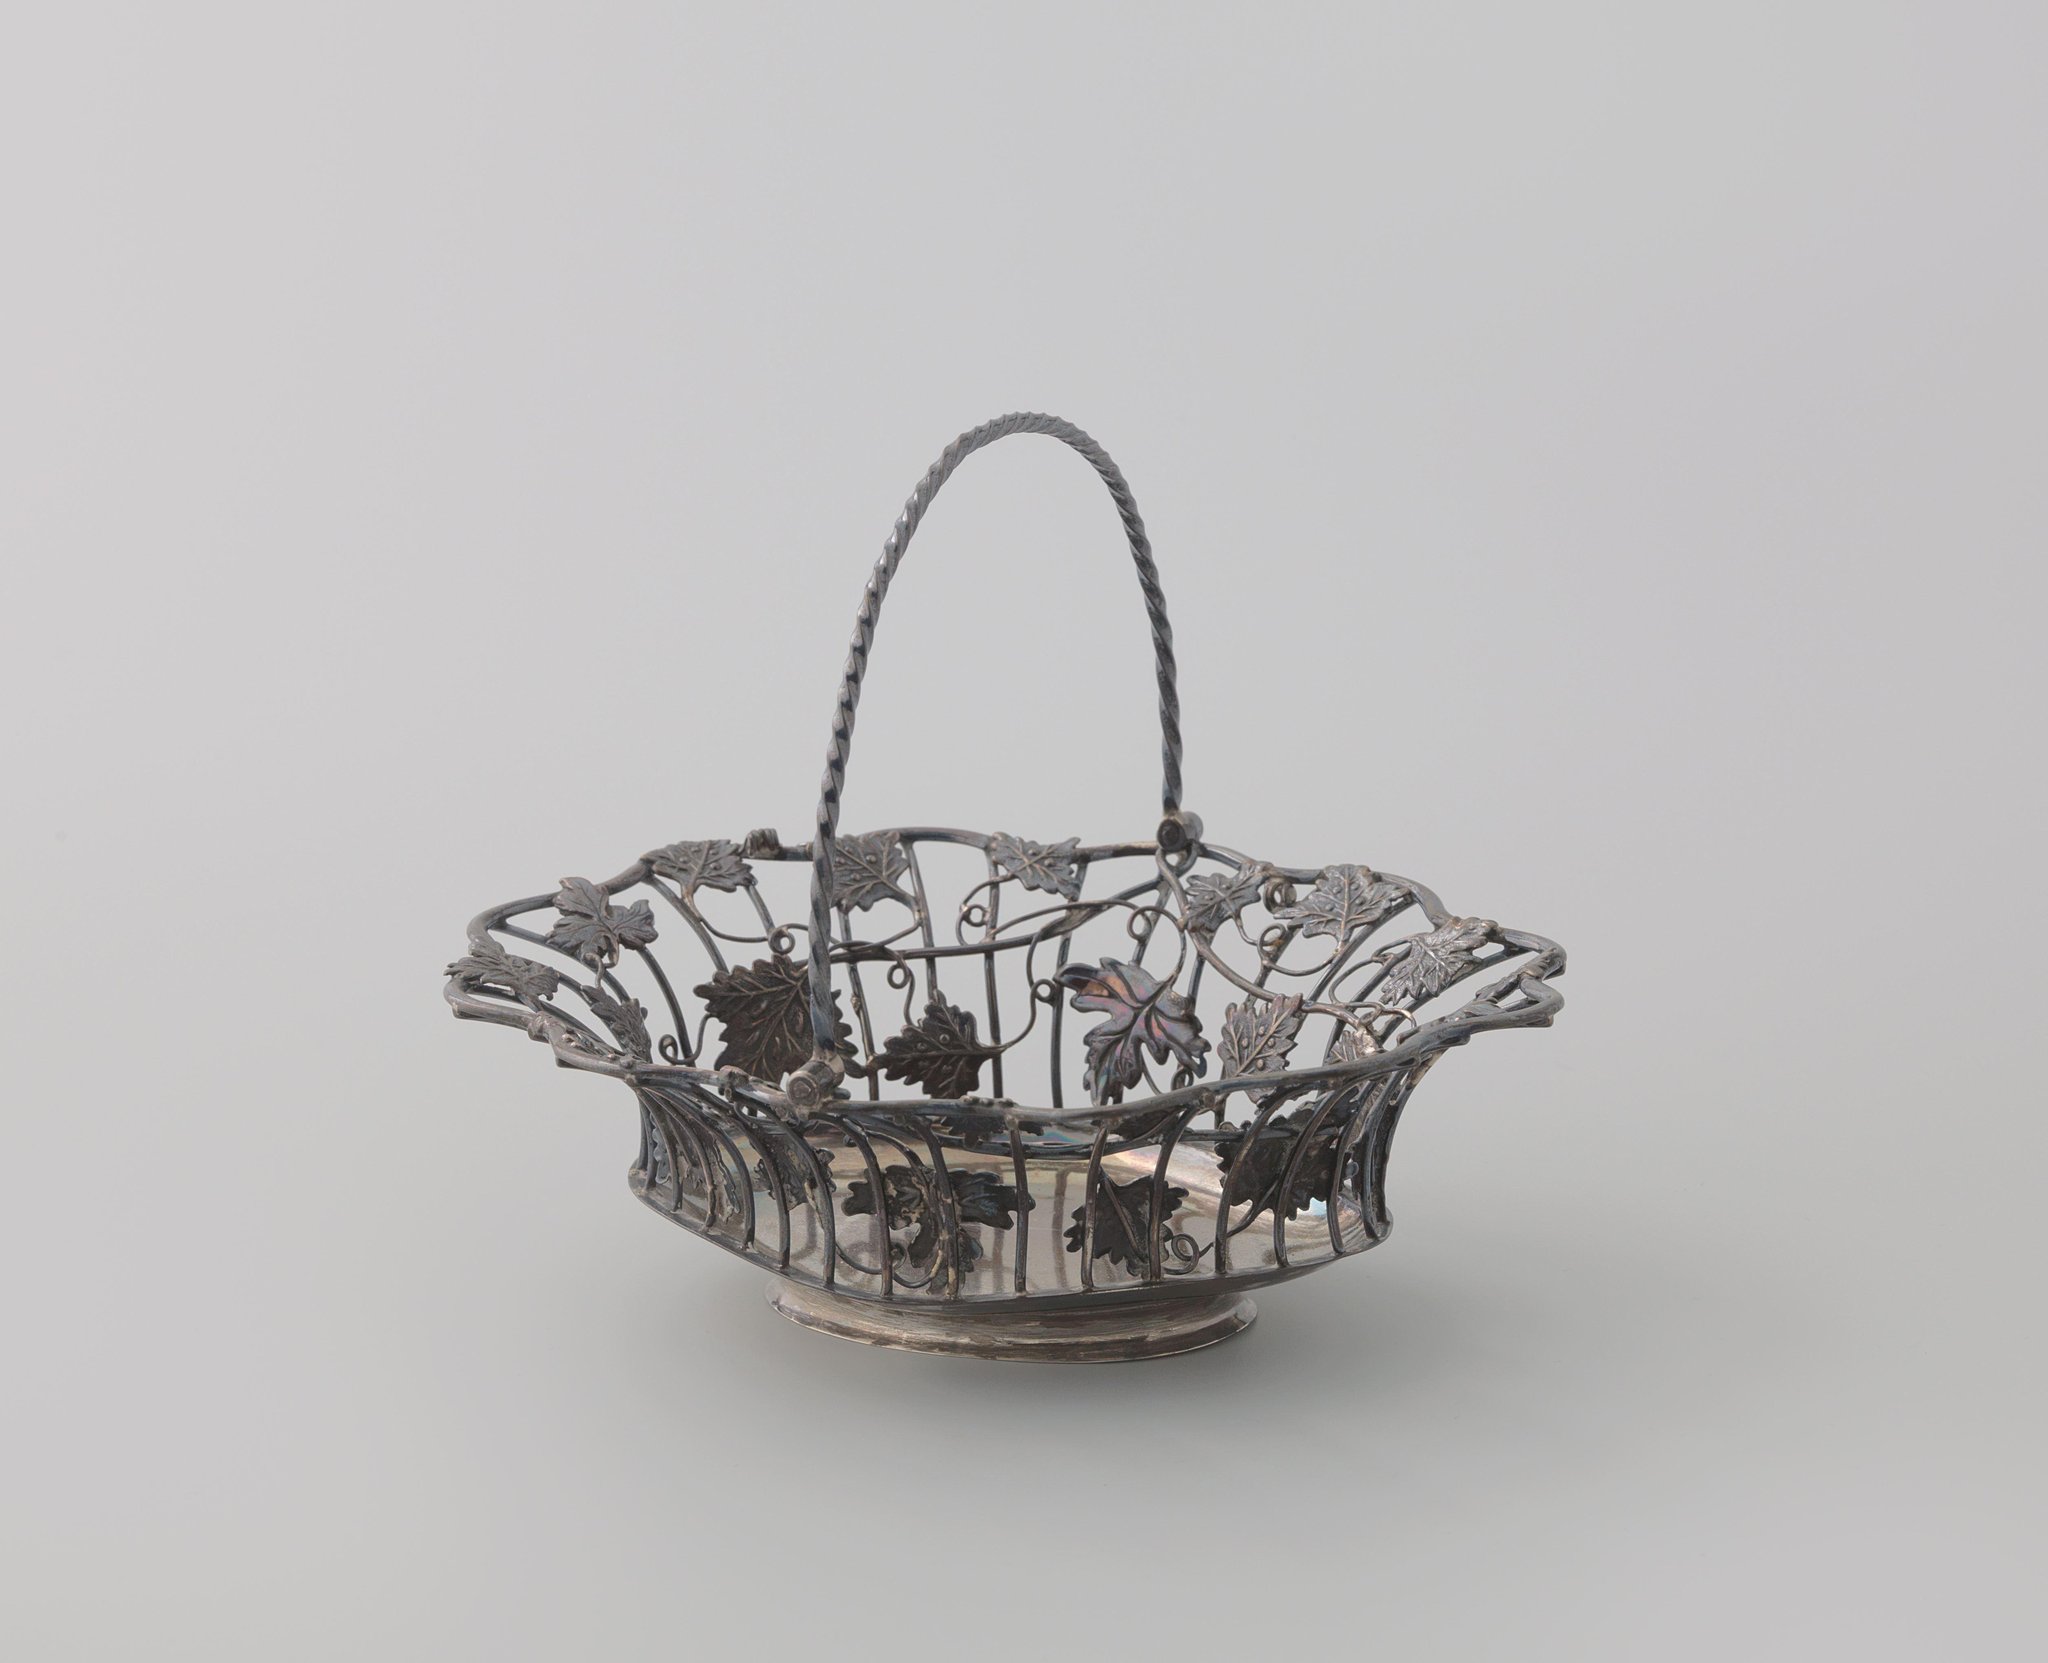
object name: ring basket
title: Hengselmand van zilver. Opgebouwd uit gebogen stangen vanaf de bodem en aan de bovenkant verbonden door een gegolfde rand. Versierd met slingerende wijnranken.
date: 1766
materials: silver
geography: london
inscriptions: mark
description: Ovale hengselmand van zilver. De wand is opgebouwd uit gebogen stangen die vanaf de bodem oprijzen en verbonden worden door een gegolfde bovenrand. Wijnranken slingeren zich over de gehele binnenzijde van de wand.